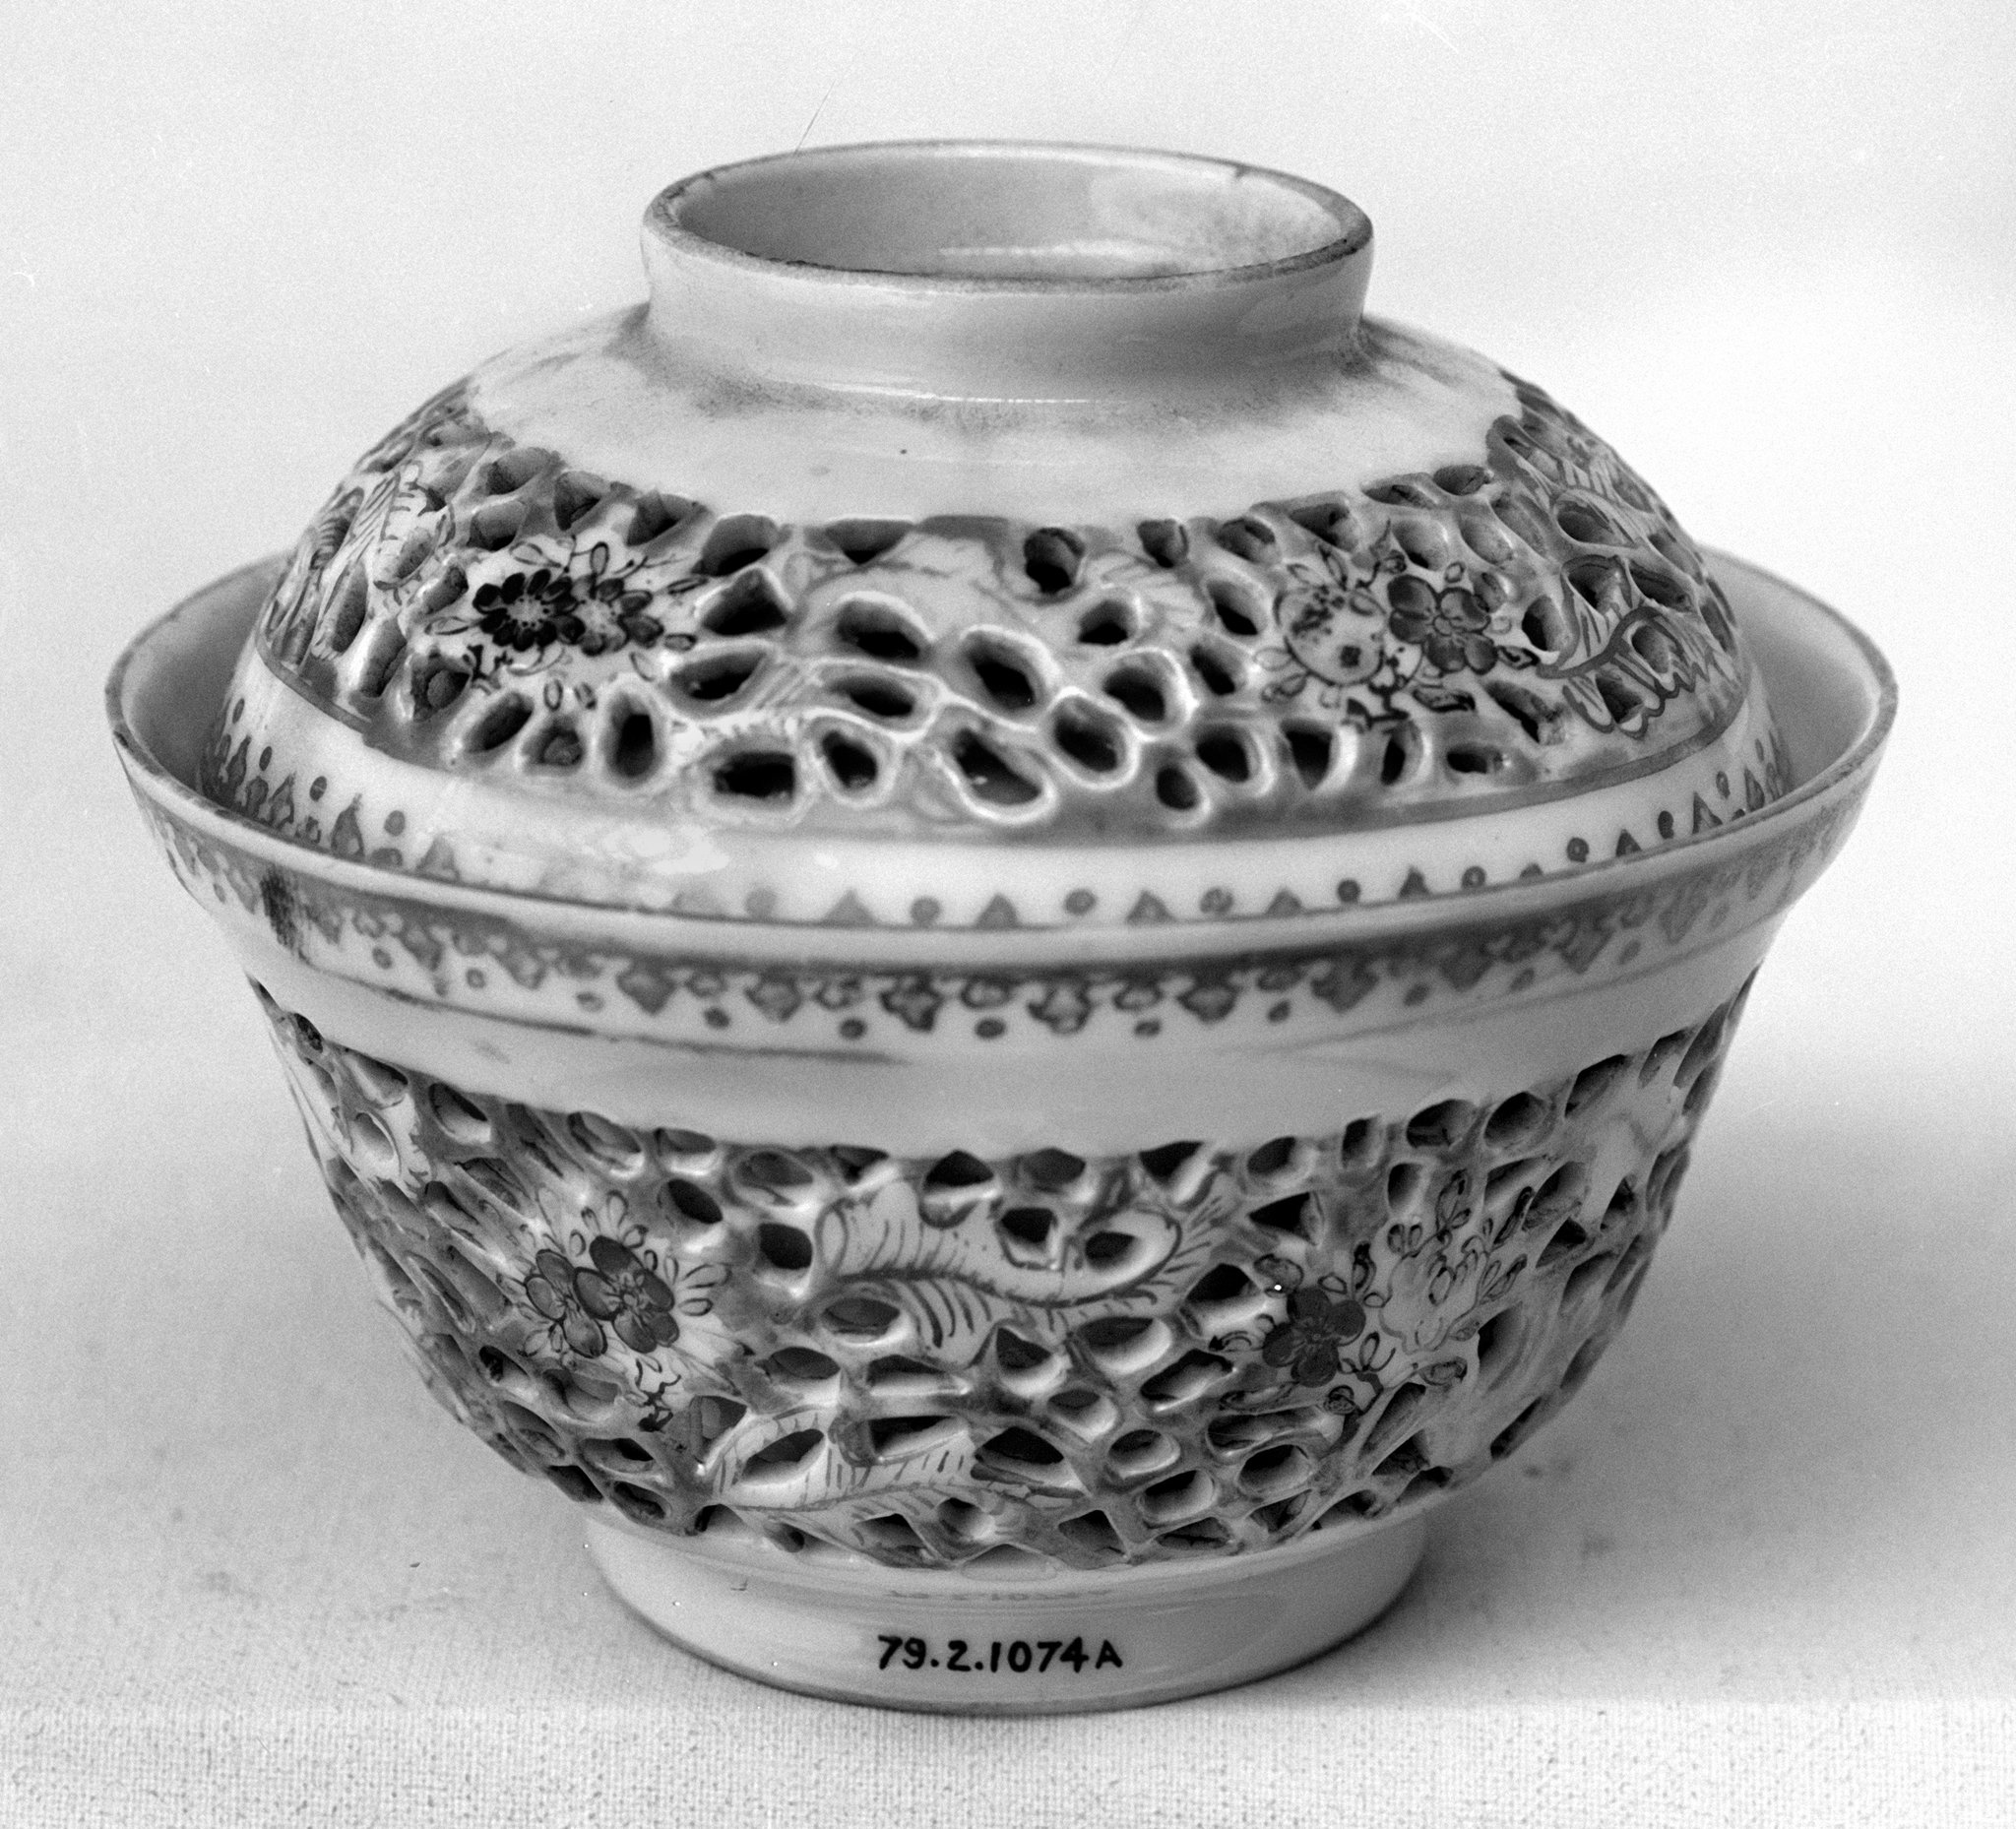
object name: covered cup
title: Covered cup with floral patterns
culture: chinese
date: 1767-1800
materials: enamel, porcelain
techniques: overglaze, painting, polychrome